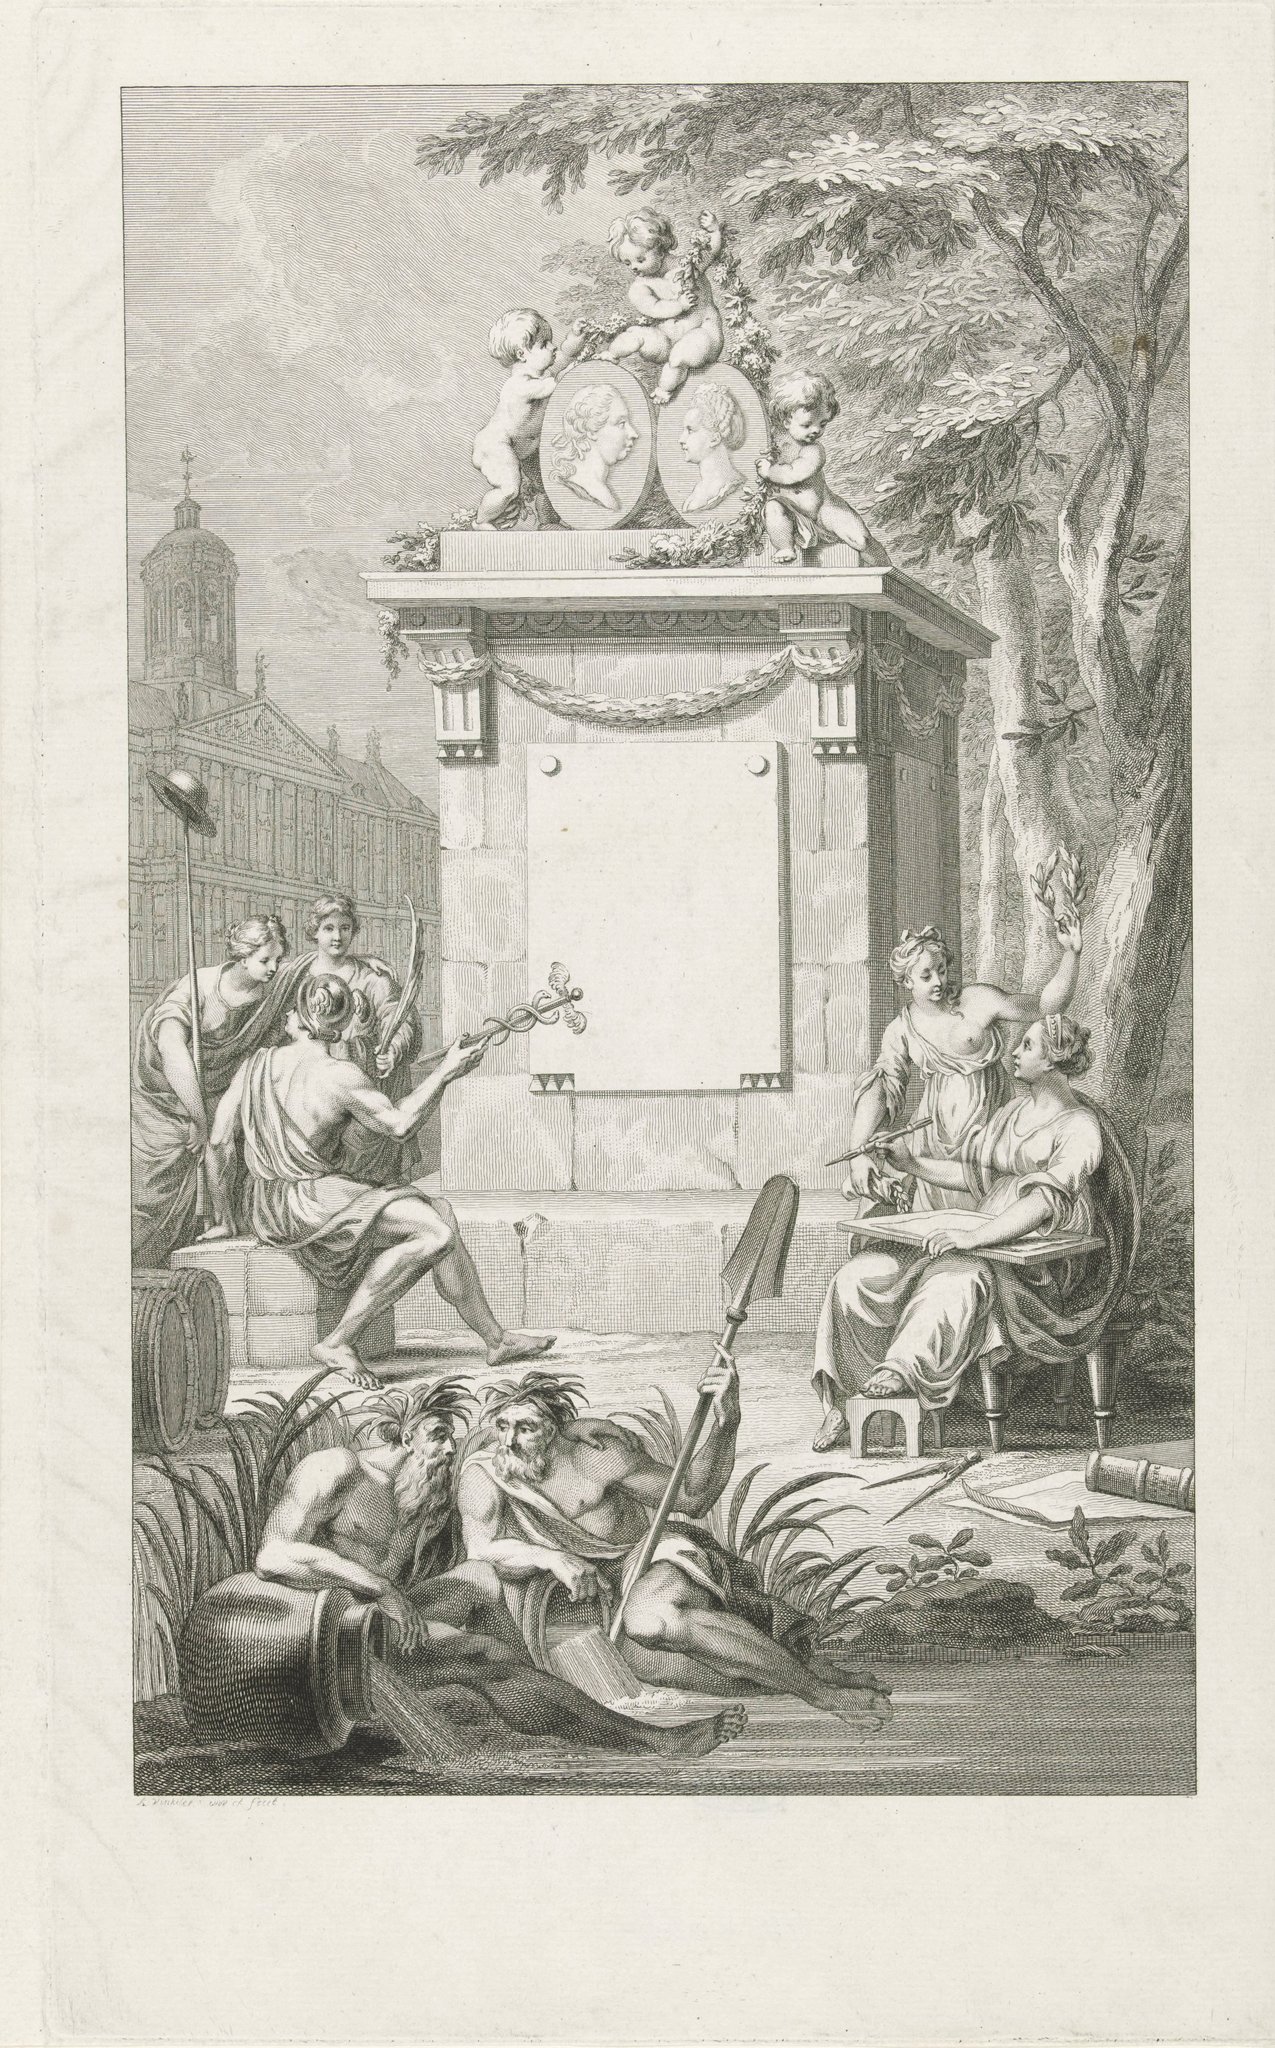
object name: print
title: Titelprent voor de prentserie van de inhaling van Willem V en Wilhelmina van Pruisen te Amsterdam, 1768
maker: reinier vinkeles (i)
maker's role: draughtsman, print maker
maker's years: 1741-1816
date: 1772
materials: paper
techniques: engraving, etching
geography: northern netherlands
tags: the hague, william v (prince of orange), berlin, painter, draughtsman, wilhelmina of prussia (princess of orange), river personified, 'fiumi' (ripa), freedom, liberty; 'libertà' (ripa), specific aspects, allegorical aspects of mercury; mercury as patron, honour, glory; 'ampiezza della gloria', 'gloria', 'gloria de prencipi', 'gloria & honore', 'honore', 'sublimatà della gloria' (ripa), symbolic representations, allegories and emblems ~ drawing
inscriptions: collector's mark: Lugt 2228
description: Titelprent voor de prentserie van de inhaling van stadhouder Willem V en prinses Wilhelmina van Pruisen te Amsterdam, 30 mei - 4 juni 1768. Allegorische voorstelling met voor een monument de Tekenkunst geïnspireerd door Eer met links Koopmanschap, Vrijheid en Vrede, op de voorgrond de riviergoden van Amstel en IJ. Op de achtergrond het Amsterdamse Stadhuis. Op het monument portretmedaillons van de prins en prinses en putti met bloemenslingers.